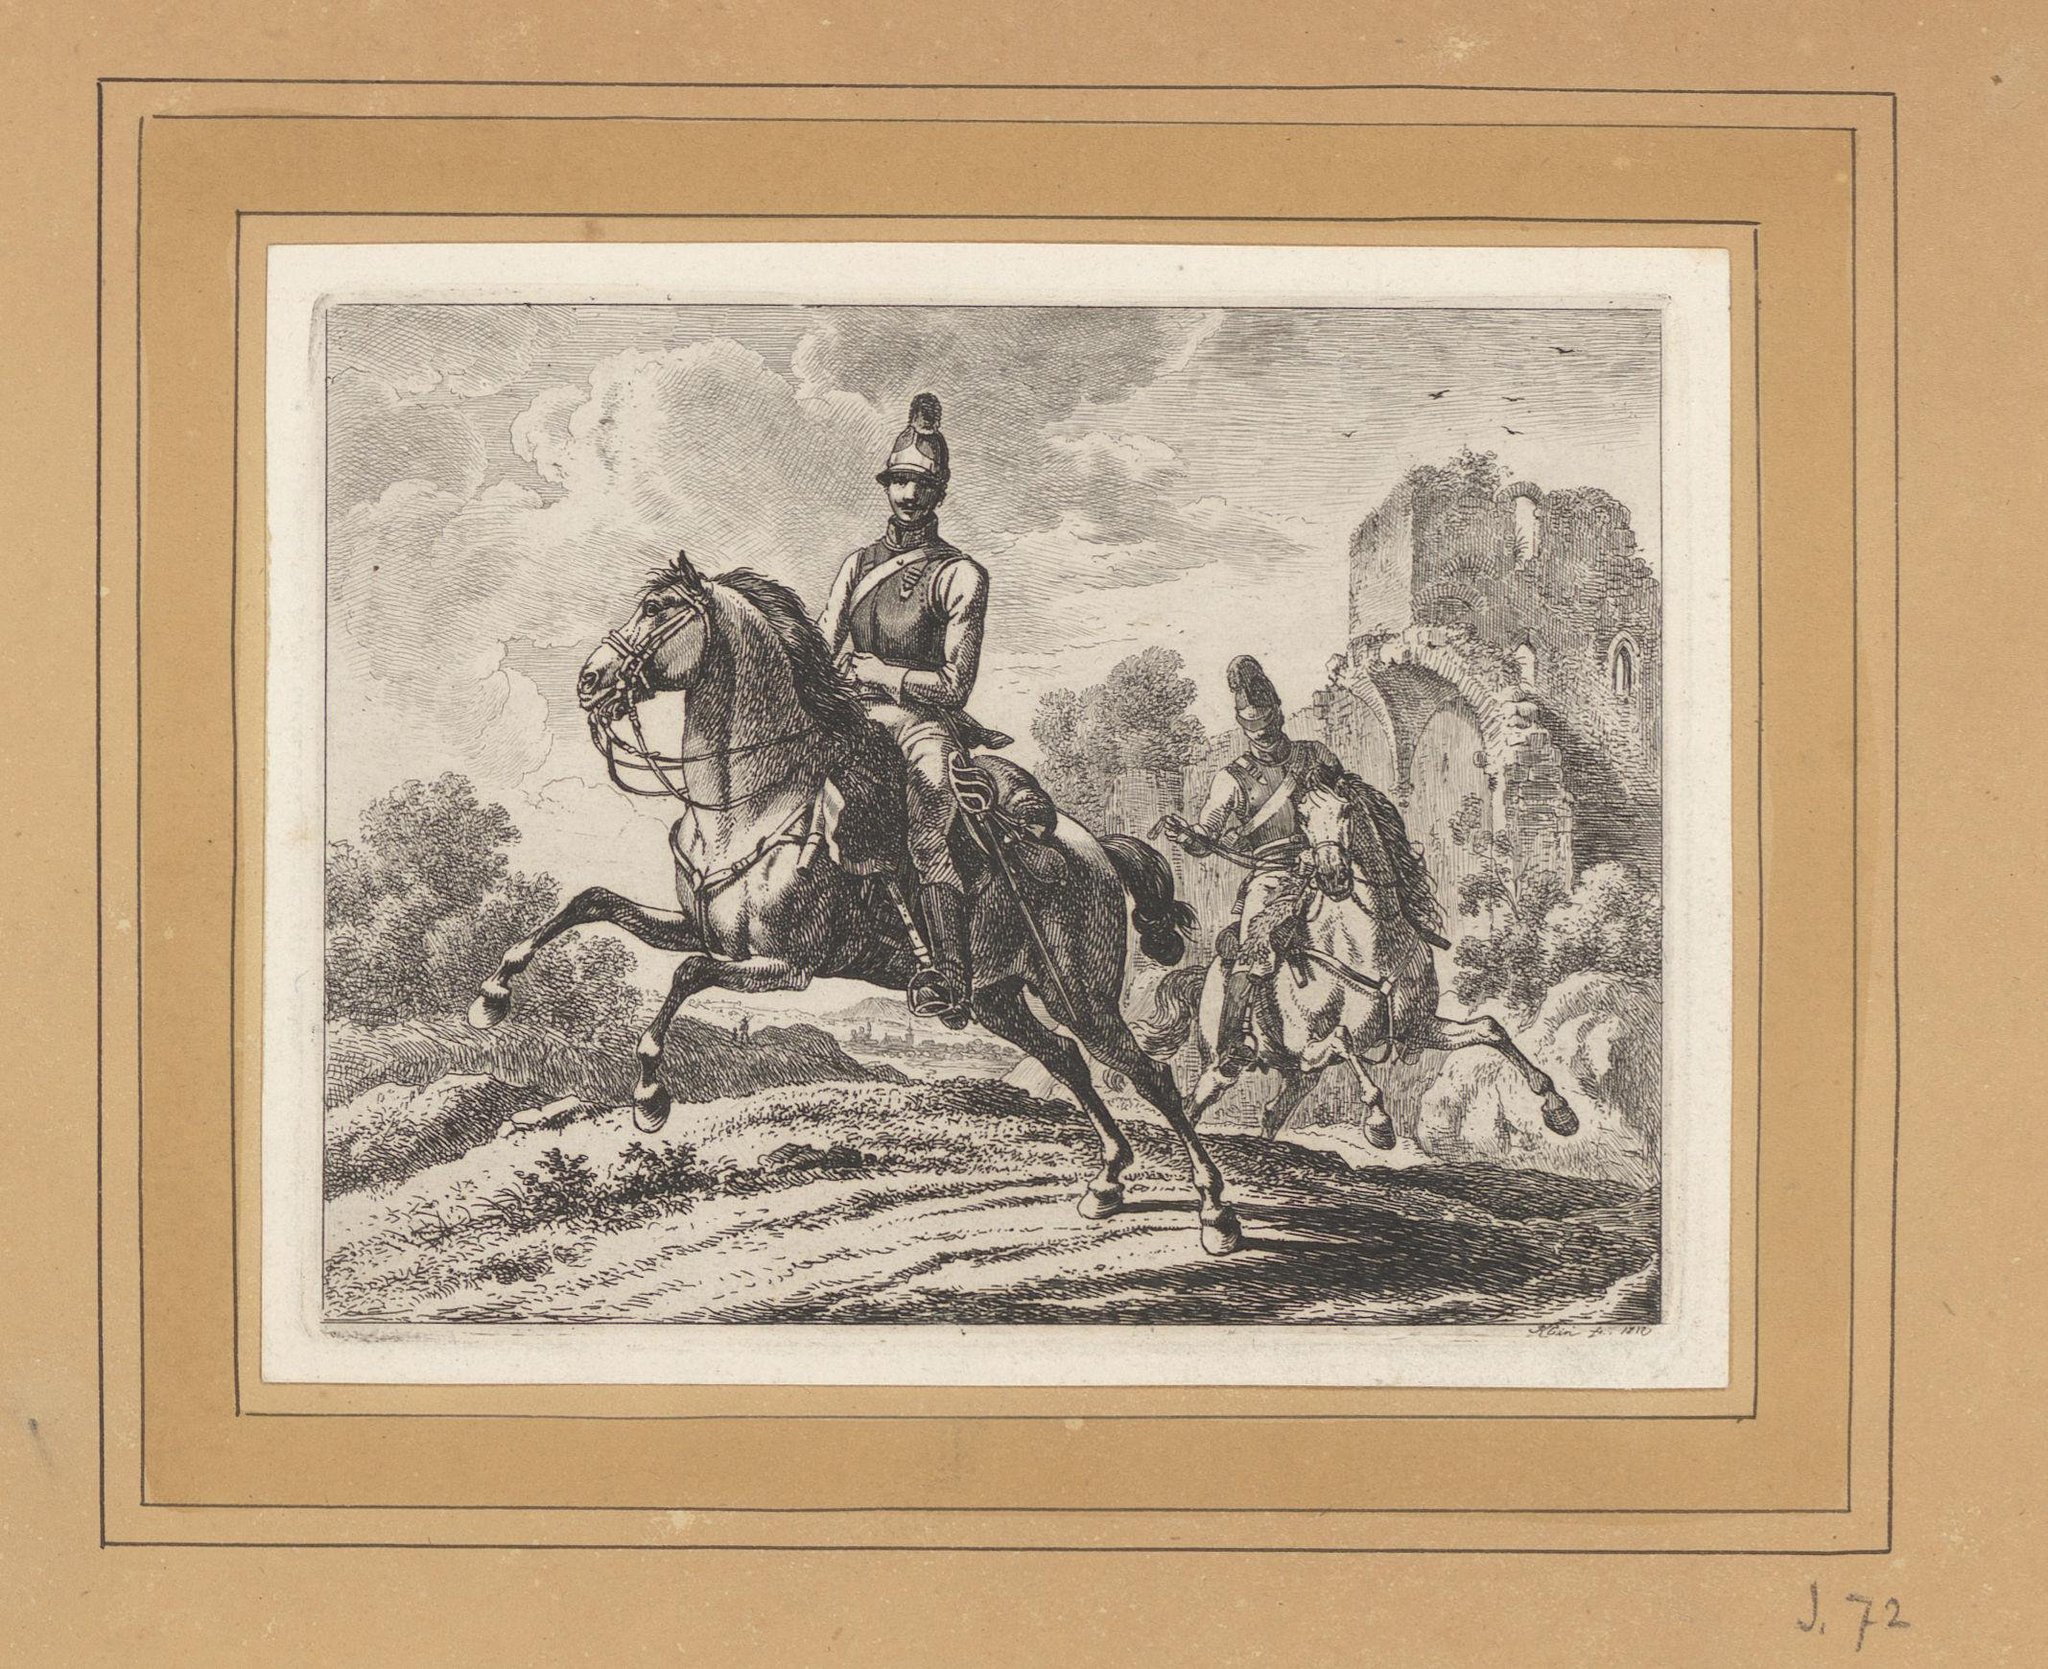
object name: print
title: Twee kurassiers in galop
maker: johann adam klein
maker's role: draughtsman, print maker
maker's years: 1792-1875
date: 1811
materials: paper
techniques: etching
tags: riding a horse, ass, or mule; rider, horseman, landscape with ruins, officer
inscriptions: collector's mark: Lugt 2760, collector's mark: Lugt 2228